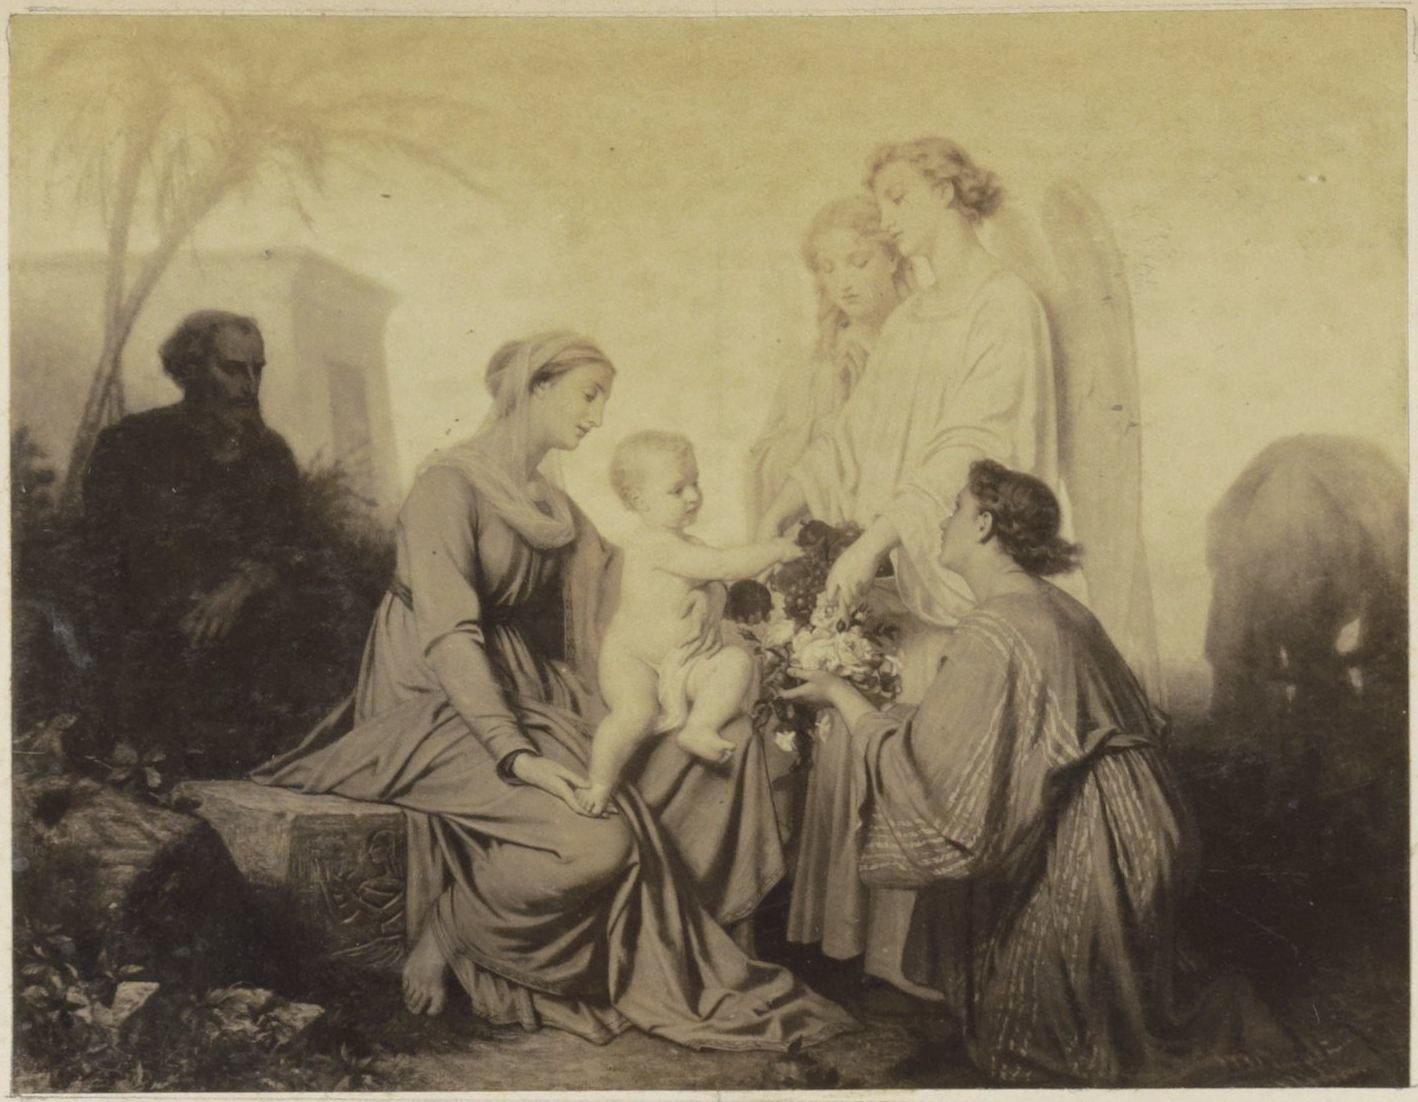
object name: reproduction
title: Fotoreproductie van (vermoedelijk) een schilderij van de Heilige Familie en drie figuren waaronder een engel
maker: Anonymous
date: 1850-1870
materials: paper, photographic support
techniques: albumen print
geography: england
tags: holy family, and derived representations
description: Onderdeel van Album met foto's van bezienswaardigheden en landschappen in Engeland en van kunst.